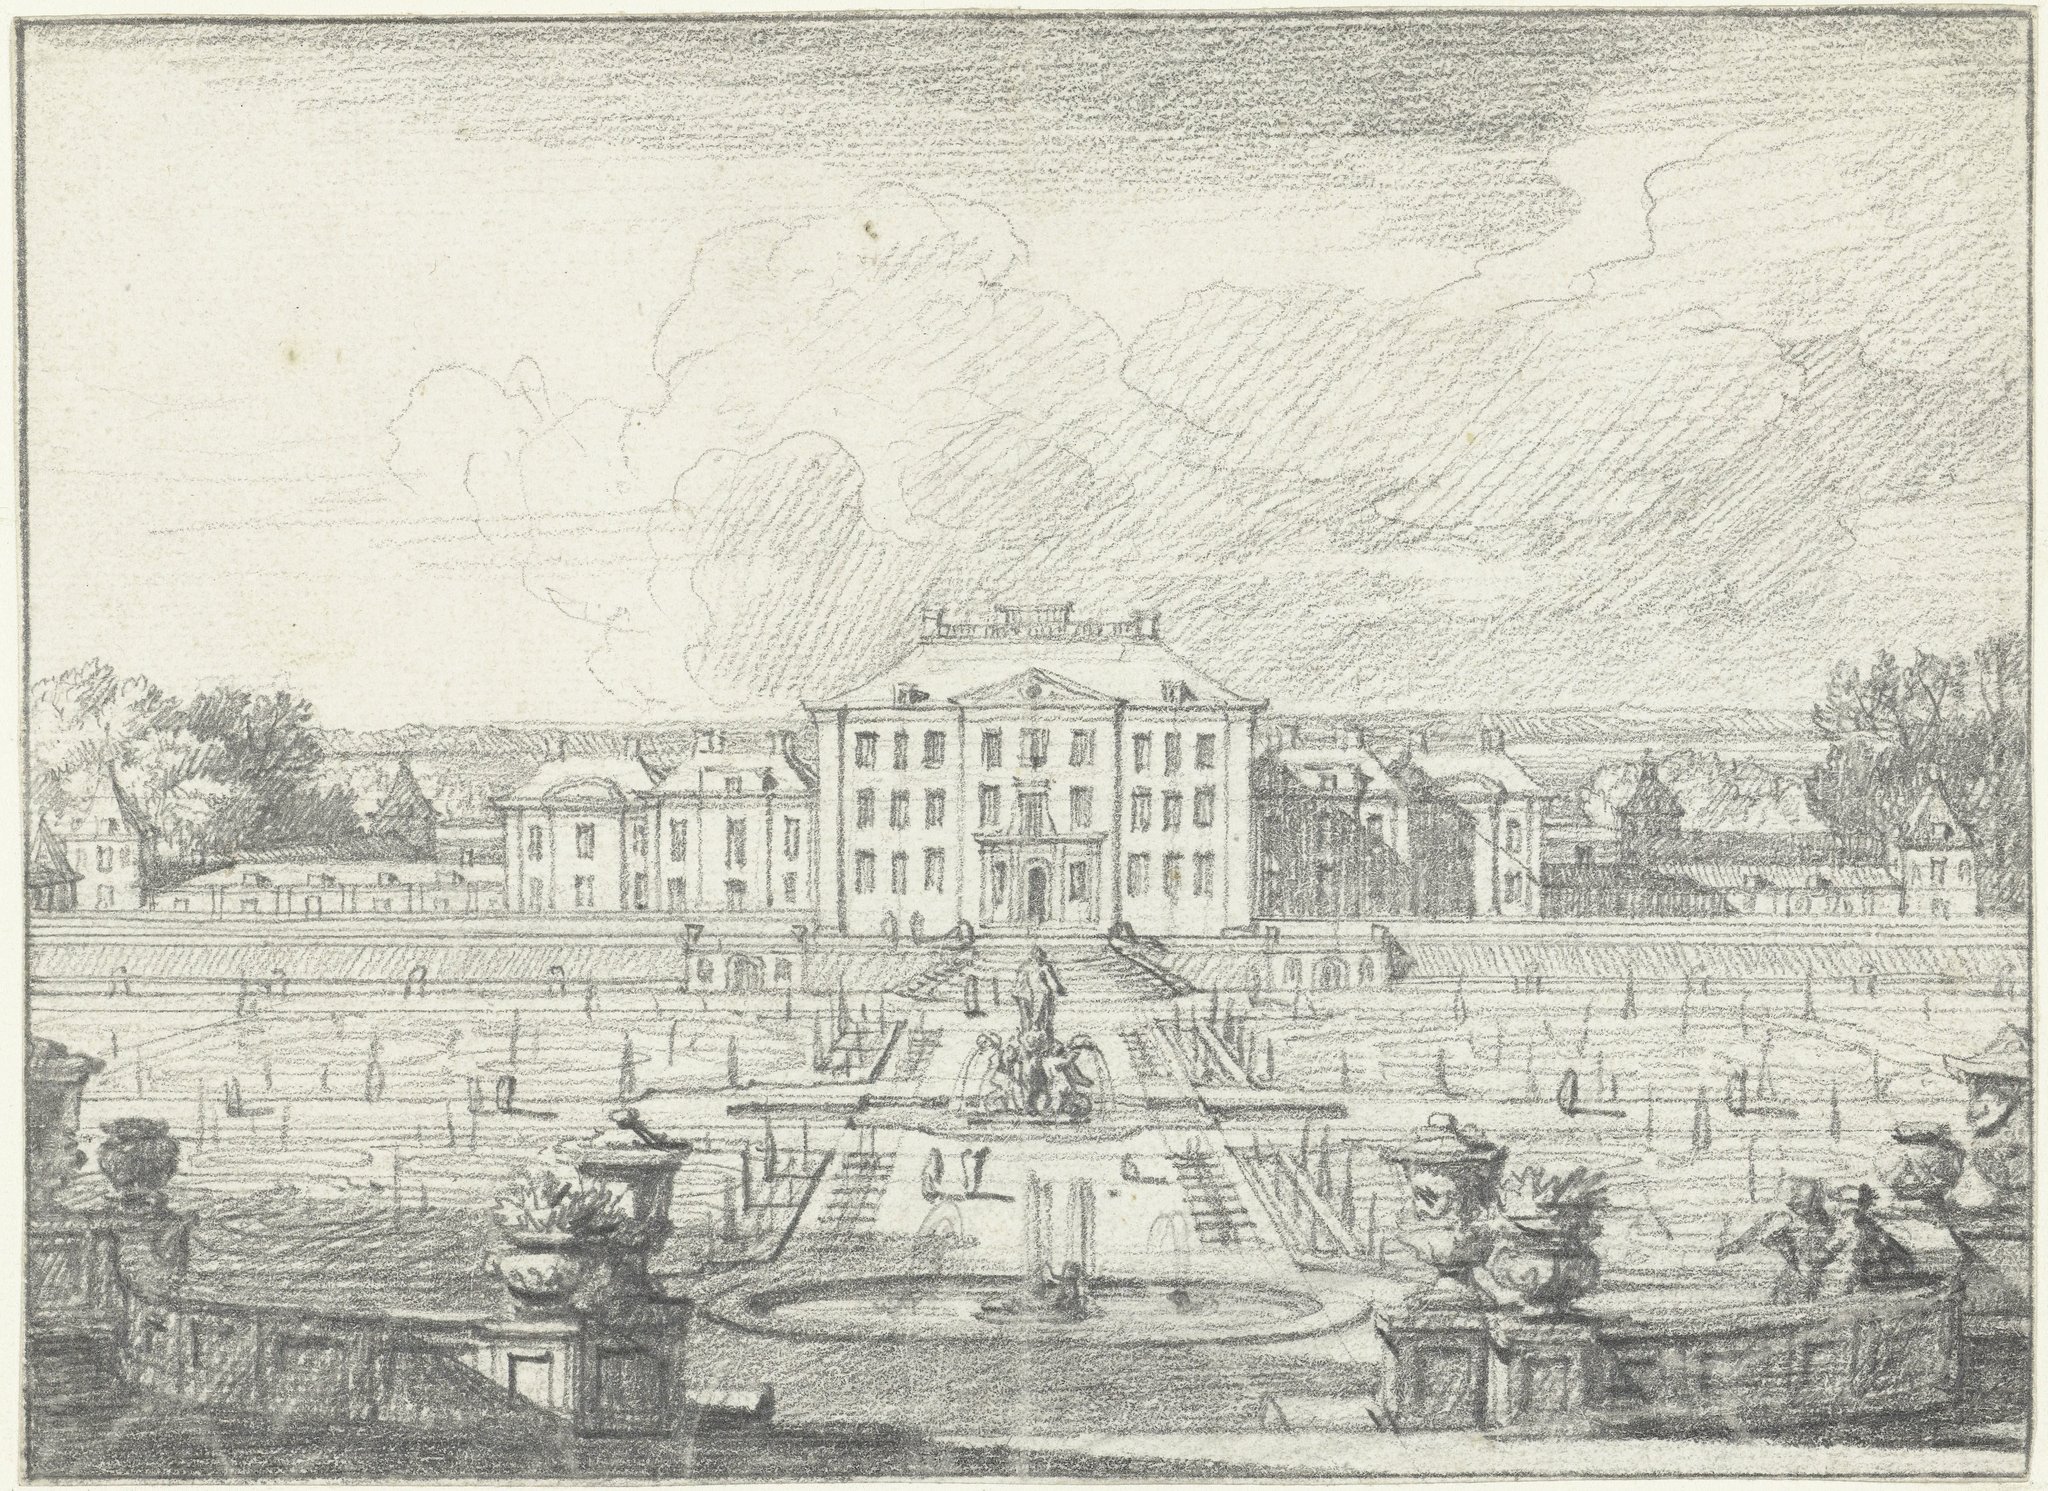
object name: drawing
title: Het Loo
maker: isaac de moucheron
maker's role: draughtsman, painter, print maker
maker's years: 1667-1744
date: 1677-1744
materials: paper, pencil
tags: castle, garden